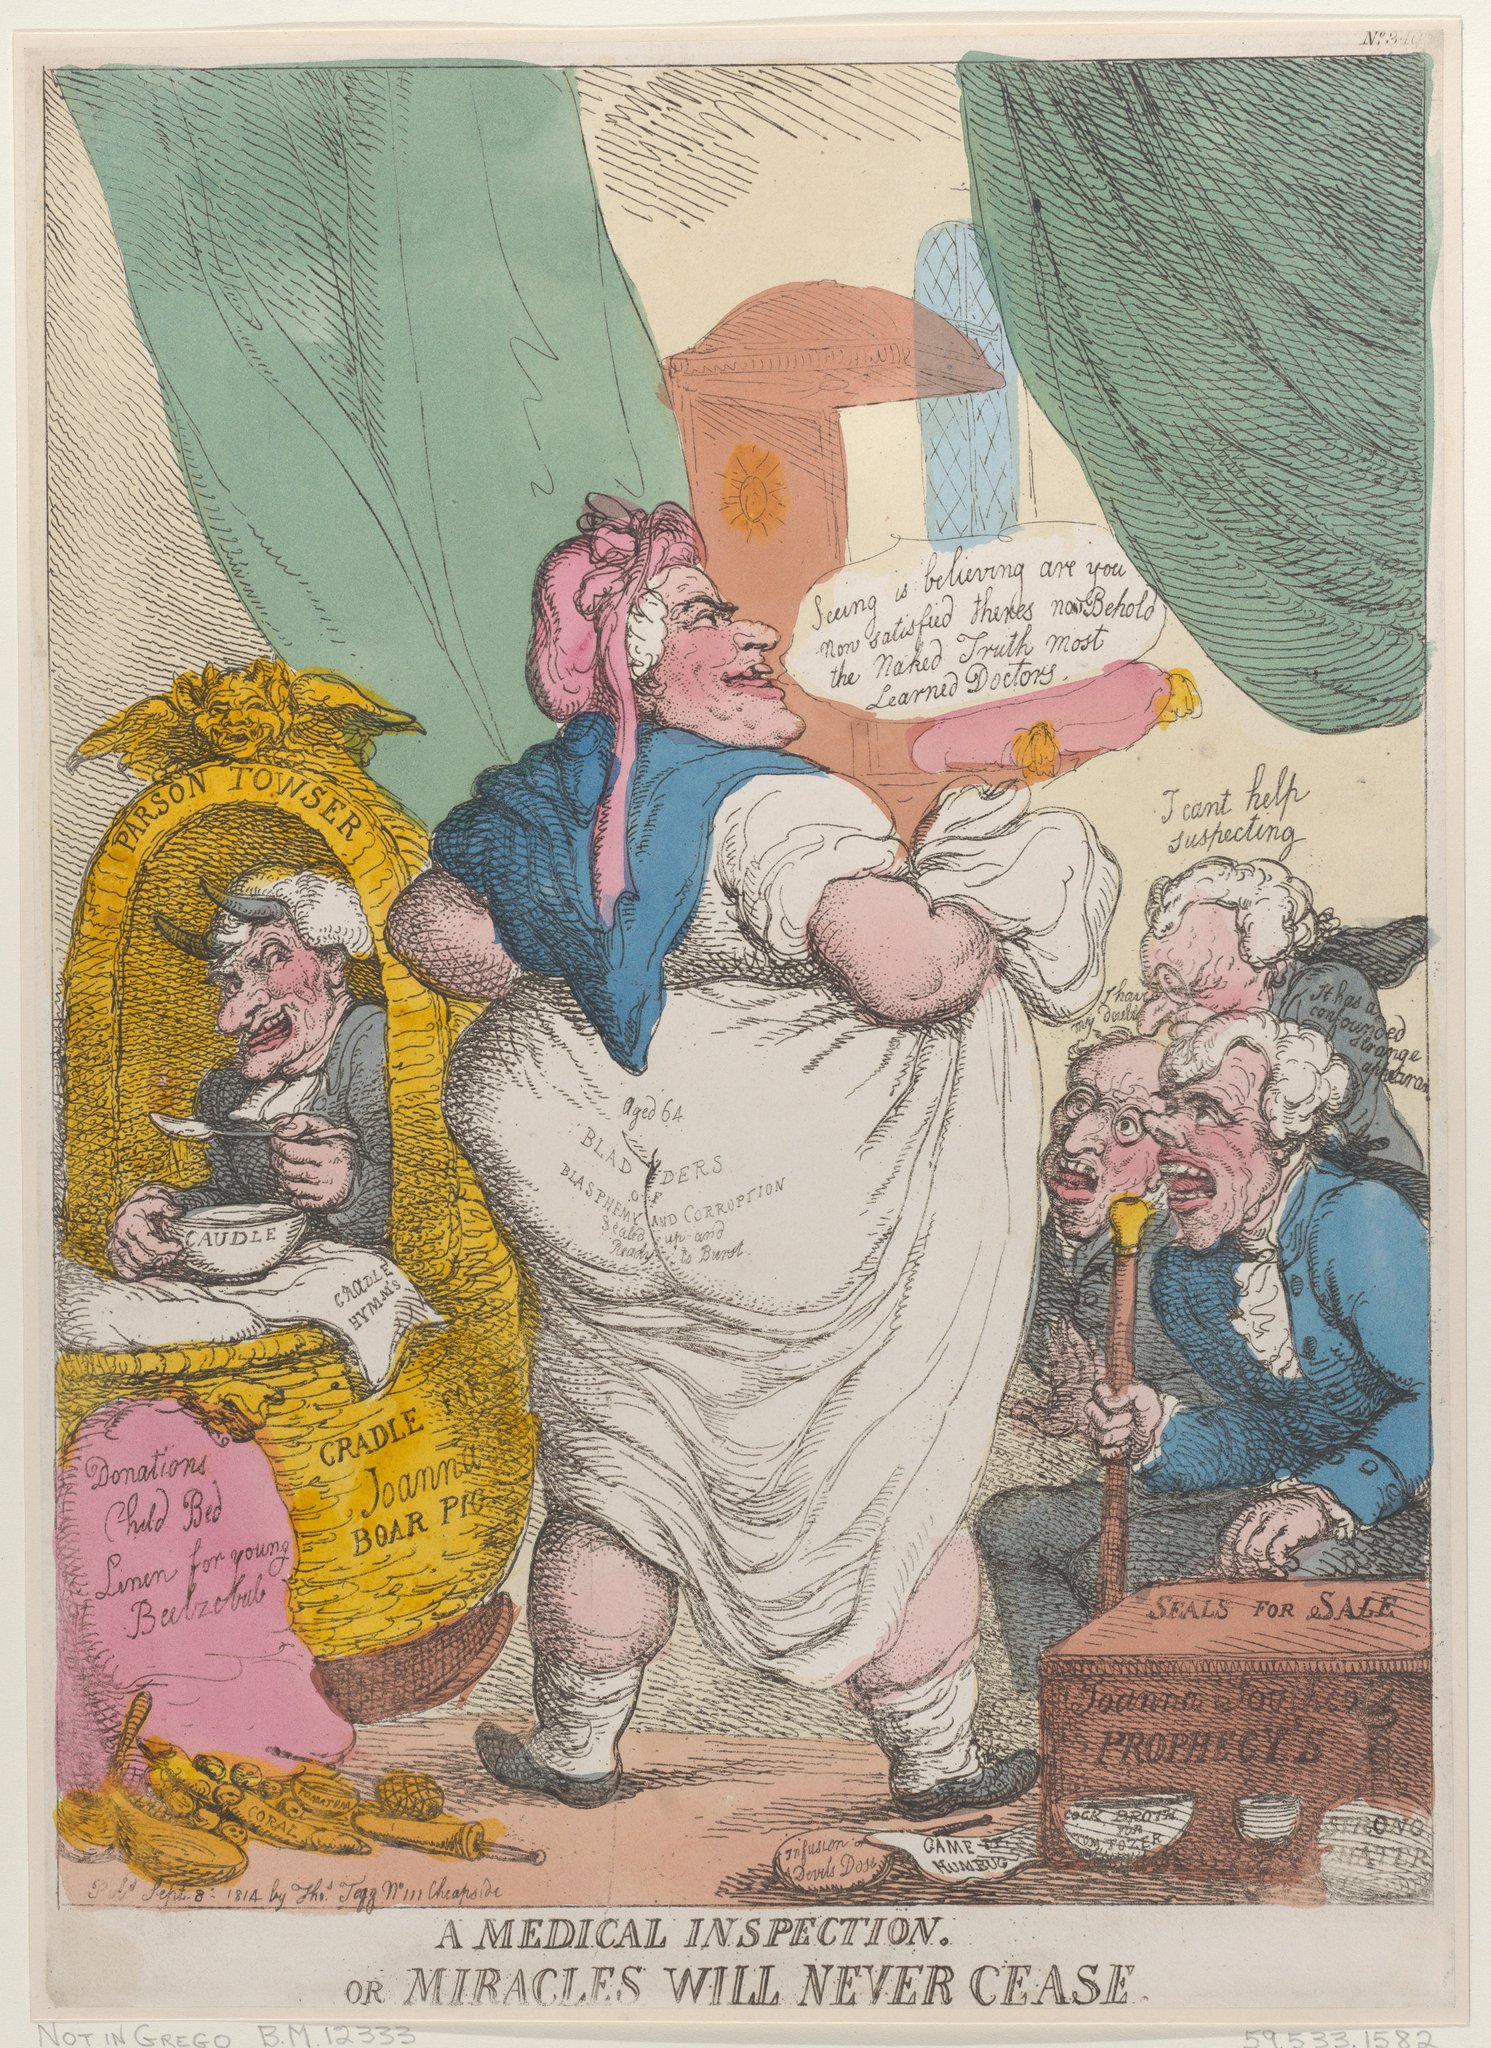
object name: print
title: A Medical Inspection or Miracles Will Never Cease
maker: thomas rowlandson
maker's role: artist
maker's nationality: british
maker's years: 1757-1827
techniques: etching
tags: men,women,caricature